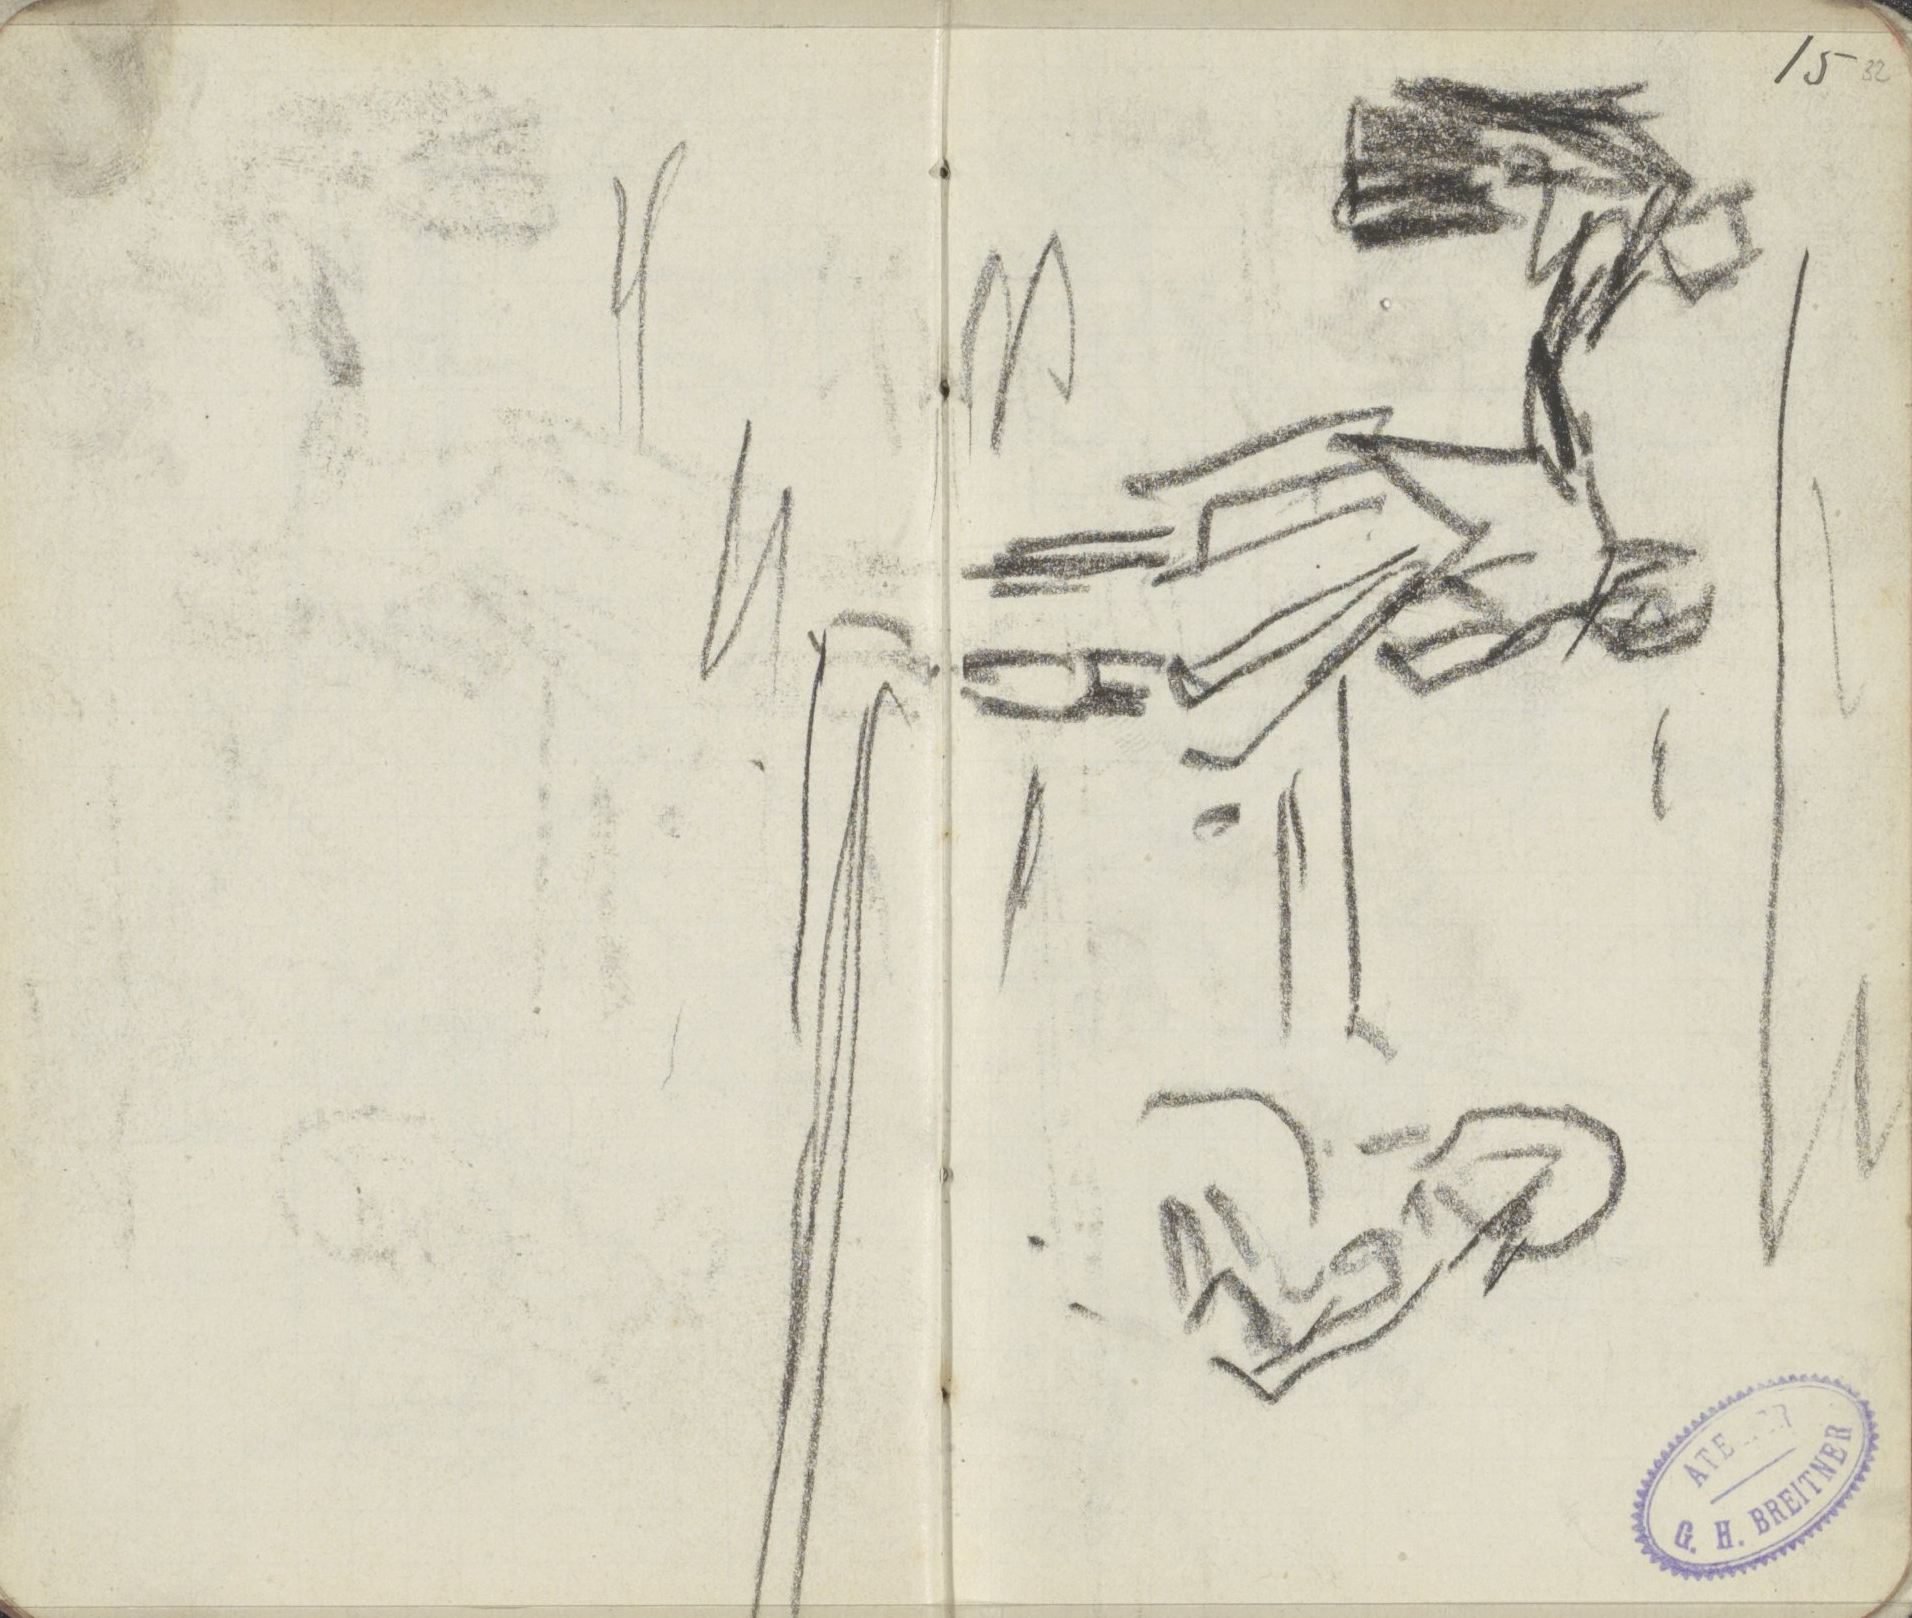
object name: sketchbook leaf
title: Kinderen, mogelijk op het strand van Scheveningen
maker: george hendrik breitner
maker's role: draughtsman, painter, print maker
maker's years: 1857-1923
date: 1896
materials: chalk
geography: scheveningen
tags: beach (as place of recreation), child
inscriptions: workshop stamp: Lugt 291d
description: Pagina 31 en pagina 32 uit een schetsboek met 20 bladen.